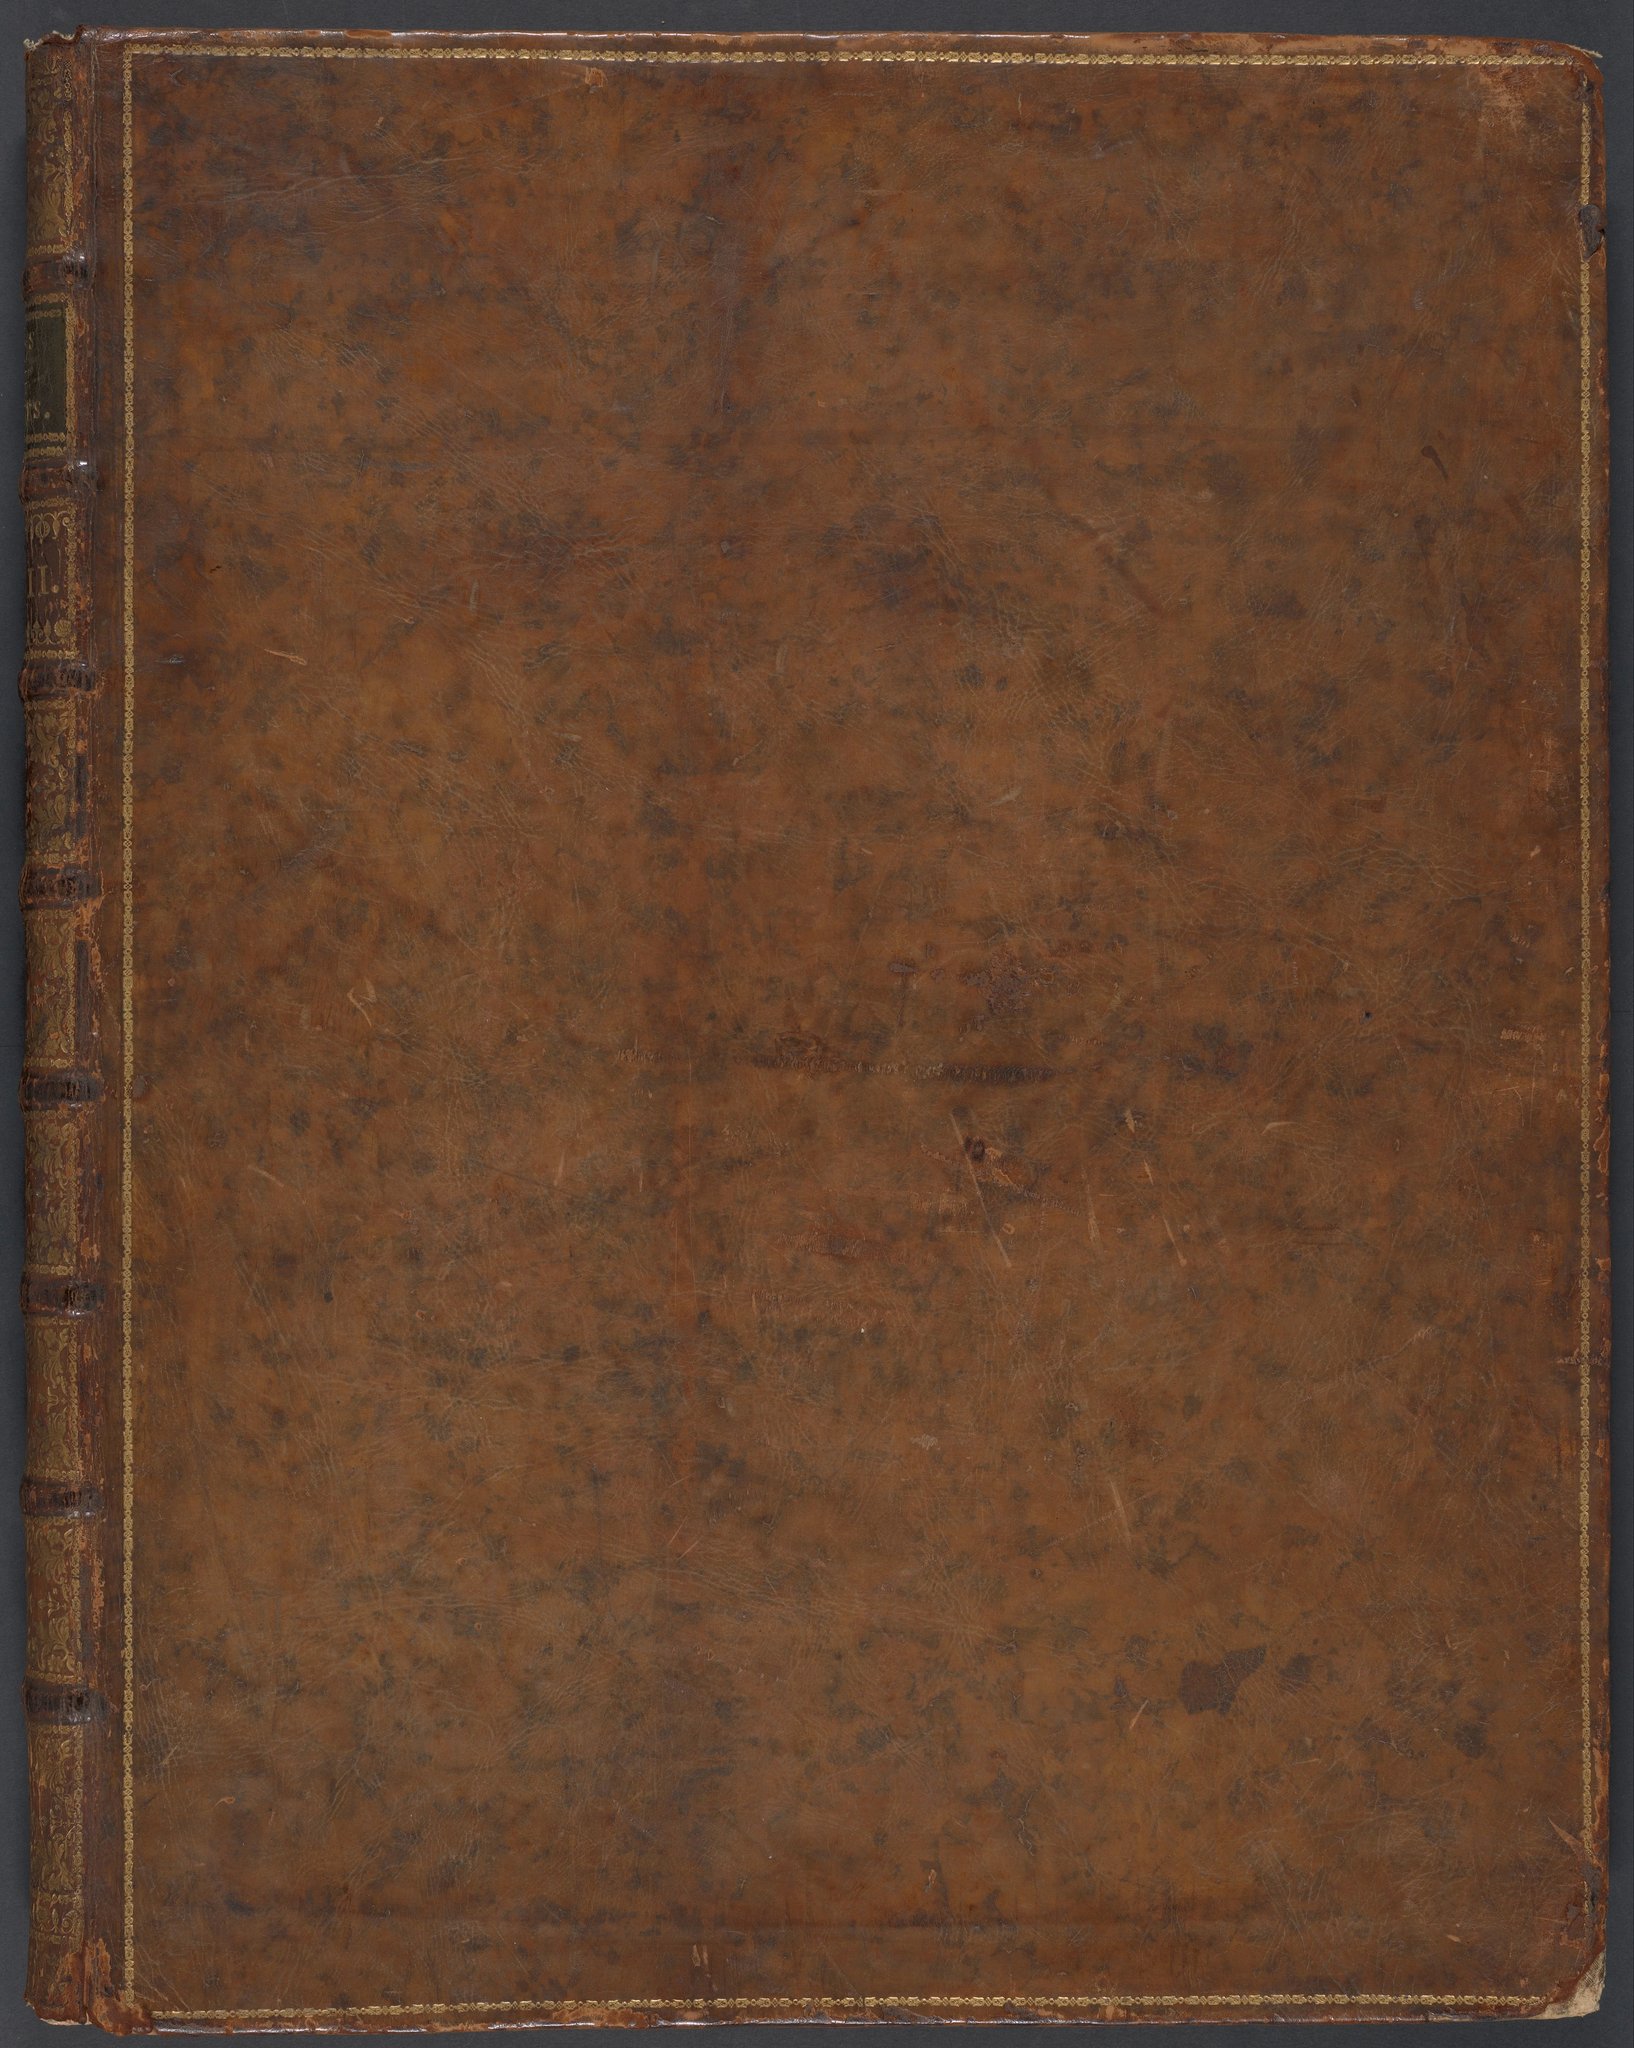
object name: drawing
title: Voyage en Italie, en Sicile et à Malte - 1778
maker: louis ducros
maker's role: draughtsman, print maker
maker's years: 1748-1810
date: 1778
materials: leather, paper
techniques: various techniques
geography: sicily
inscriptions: date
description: Album met leren band met goudopdruk waarin aquarellen en tekeningen van reisgezichten in Zuid-Italië en op Sicilië en Malta. Op 26 januari 1778 verlieten Willem Carel Dierkens en Willem Hendrik van Nieuwerkerke Den Haag voor een reis naar Zuid-Italië, Sicilië en Malta. Later sloten ook Nicolaas ten Hove, Nathaniel Thornbury en de Zwitserse kunstenaar Louis Ducros zich bij hen aan. Ducros legde onderweg de bezienswaardigheden vast, welke door Ten Hove thuis na de reis werden gemonteerd in drie albums. Dit derde album bevat tekeningen van landschappen, stadsgezichten, antieke monumenten en scènes uit het dagelijks leven onderweg.